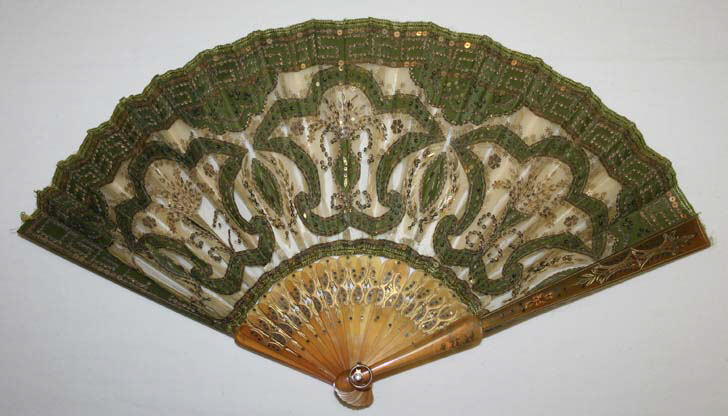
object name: fan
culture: american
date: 1850-1860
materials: silk, shell